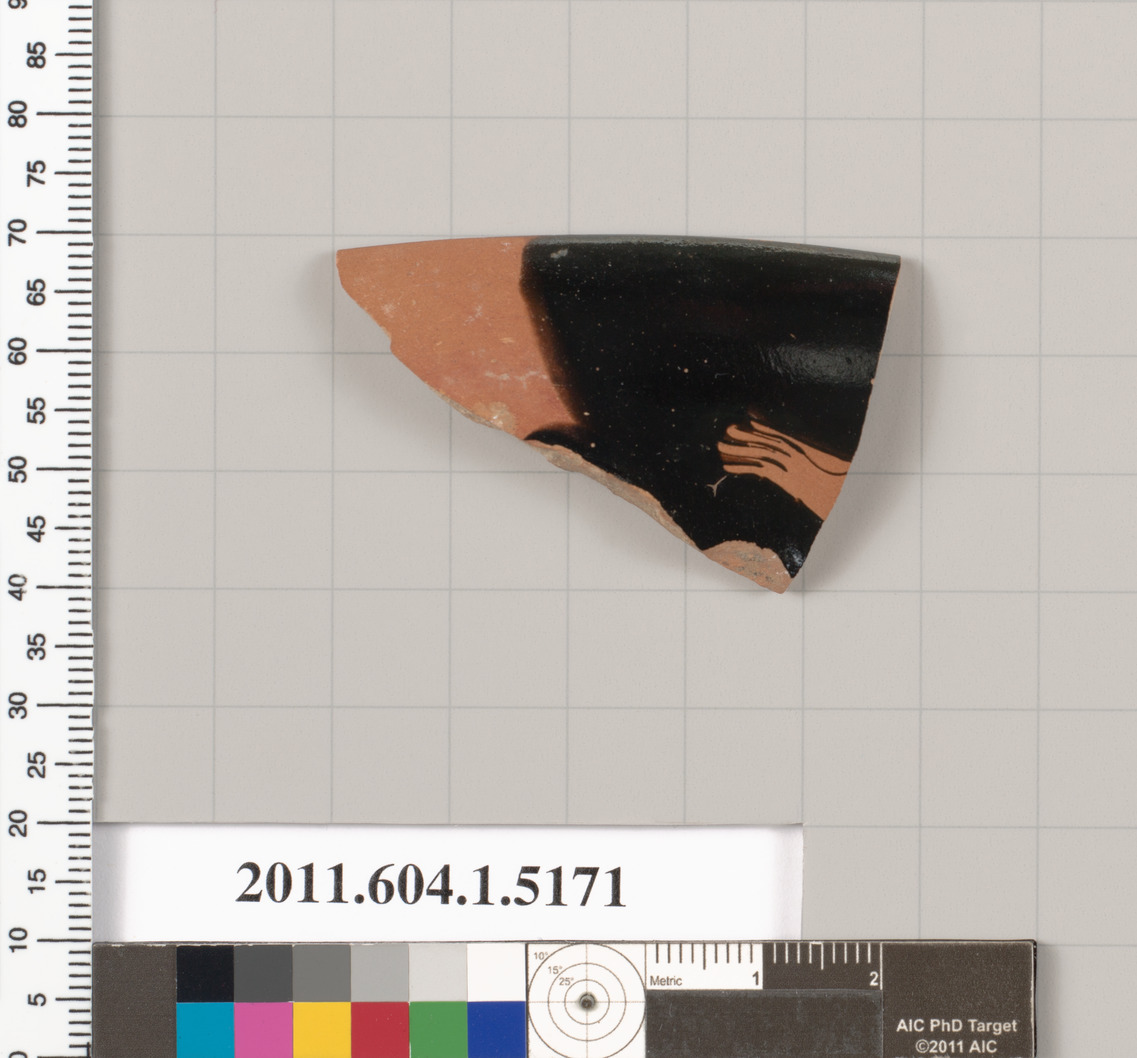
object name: kylix fragment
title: Terracotta rim fragment of a kylix (drinking cup)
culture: greek, attic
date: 500-480 BCE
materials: terracotta